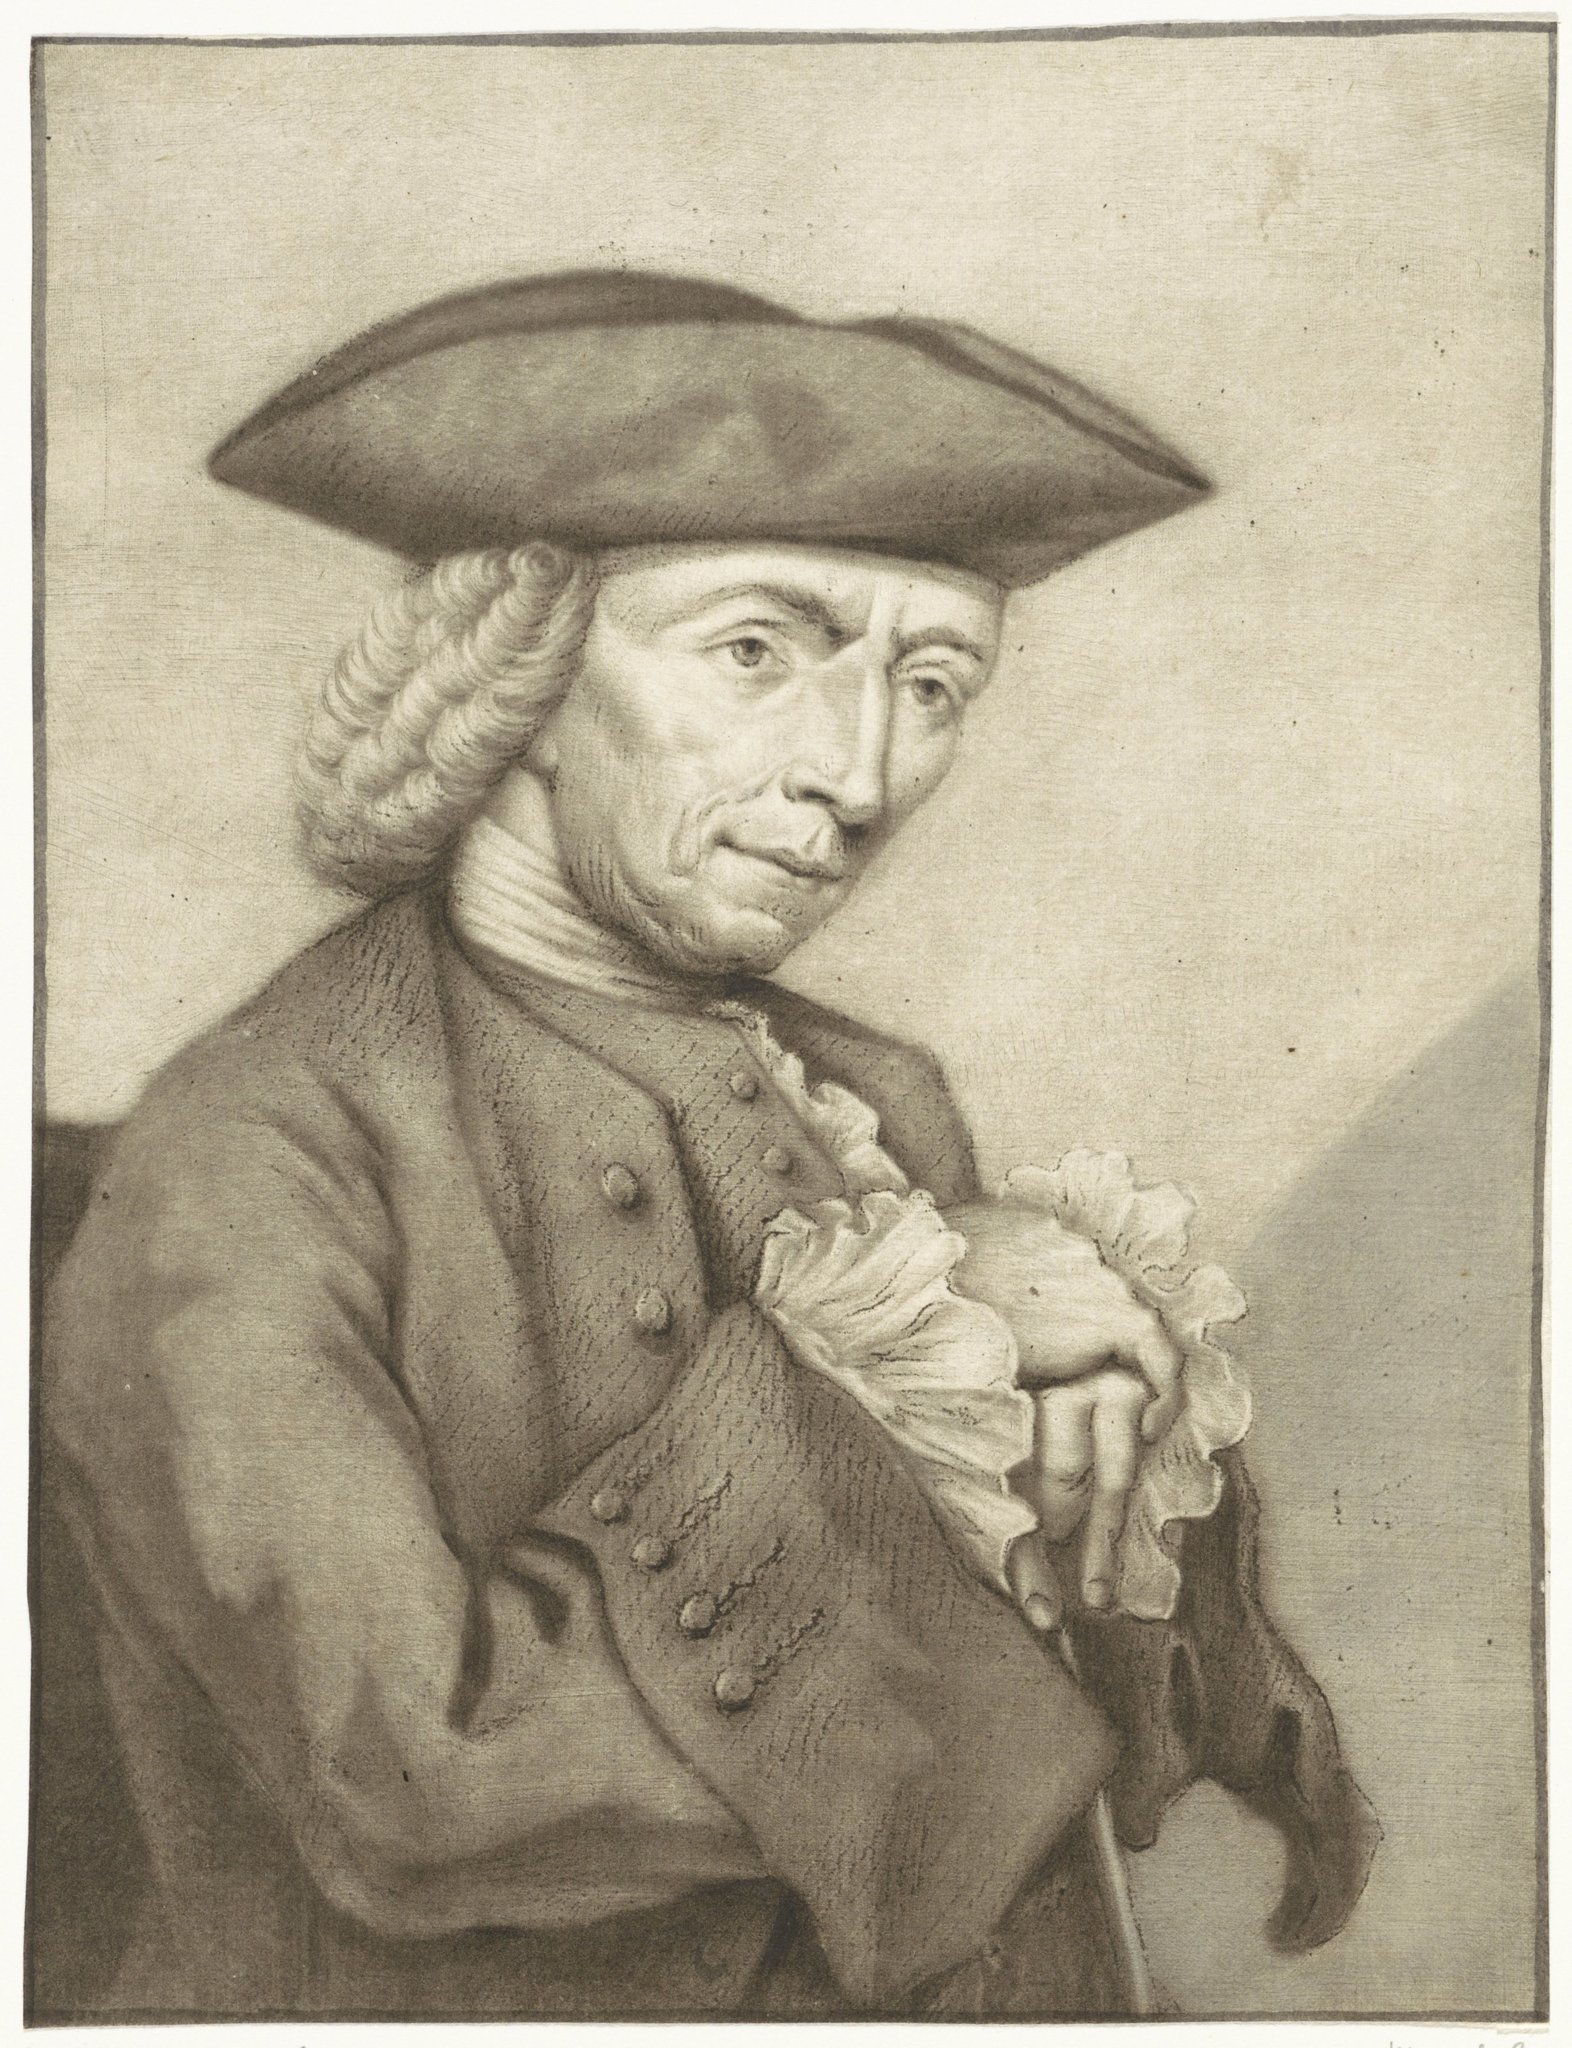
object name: print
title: Portret van Hendrik Spilman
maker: pieter louw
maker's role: draughtsman, print maker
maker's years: 1725-1800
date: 1743-1800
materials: paper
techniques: mezzotint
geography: amsterdam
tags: amsterdam, print maker, draughtsman, pieter louw, head-gear: hat (+ men's clothes), portrait, self-portrait of artist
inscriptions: collector's mark: Lugt 2760, collector's mark: Lugt 2228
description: De prentmaker, tekenaar en schilder Hendrik Spilman. Hij laat zijn over elkaar gevouwen handen op zijn wandelstok rusten.